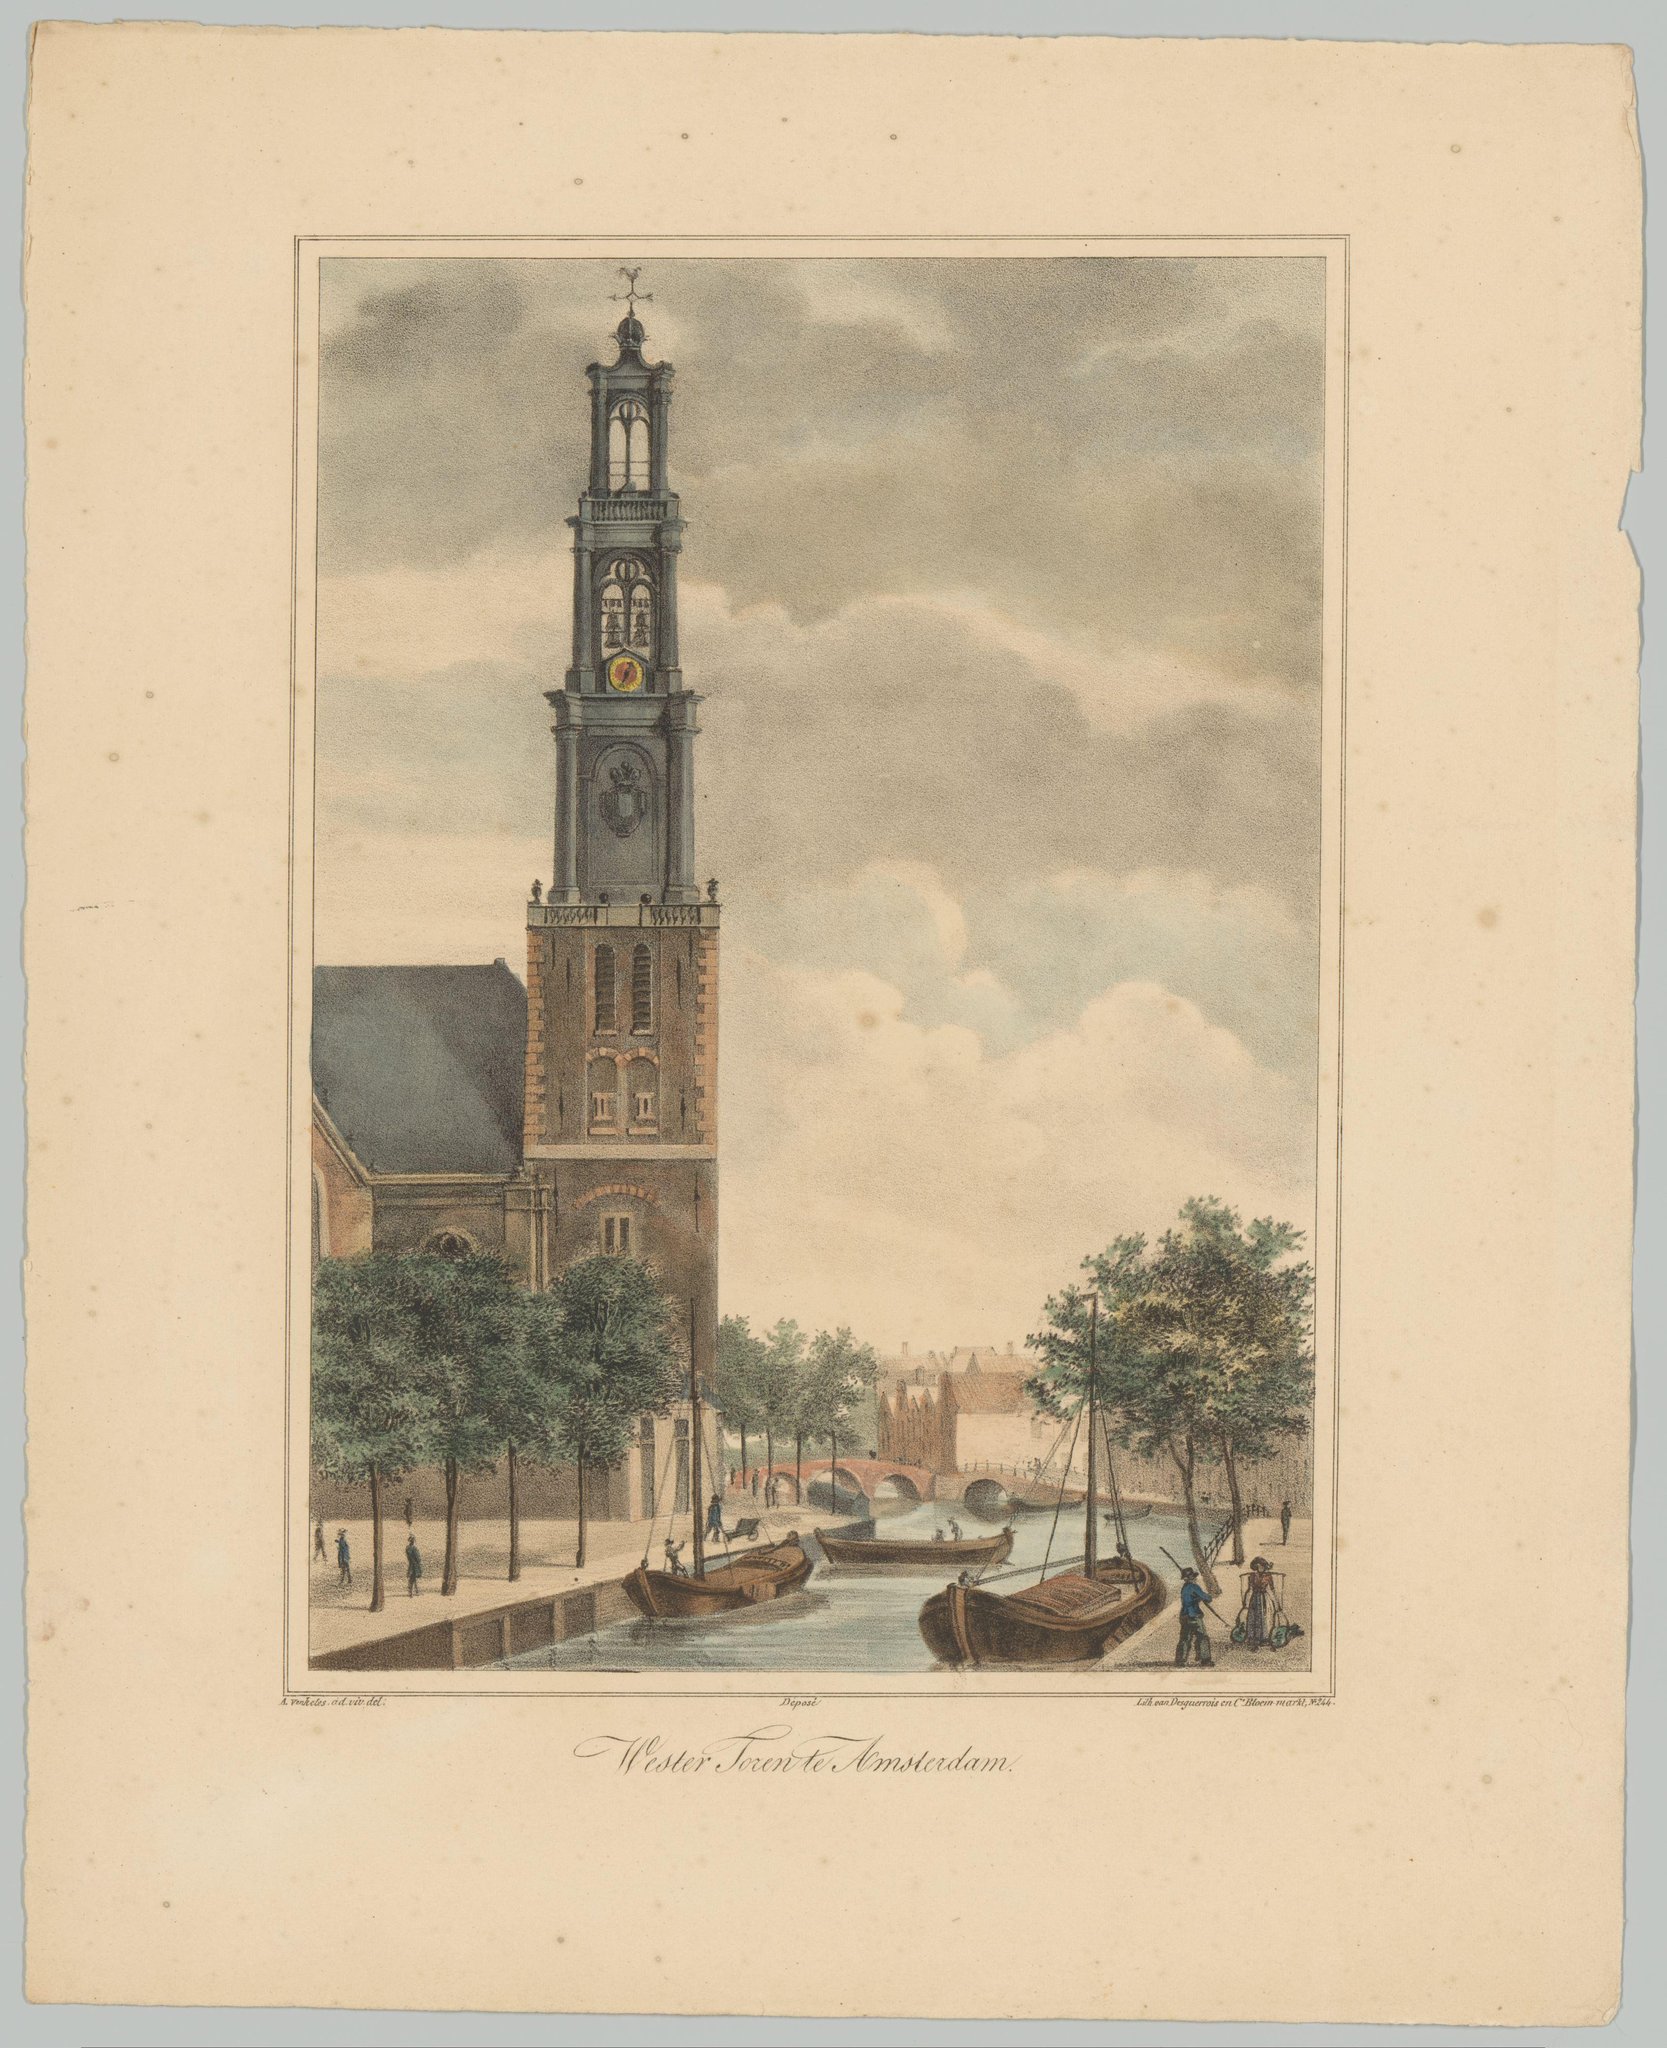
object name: print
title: Gezichten van de Zes Voornaamste Torens der Stad Amsterdam. 2de Cahier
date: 1828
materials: paper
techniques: hand coloring, lithograph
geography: amsterdam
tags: tower, clock tower ~ monumental adornment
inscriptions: collector's mark: Lugt 2228, : ‘Déposé.’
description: Onderdeel van een omslag met een serie van zes lithografieën van Amsterdamse torens.